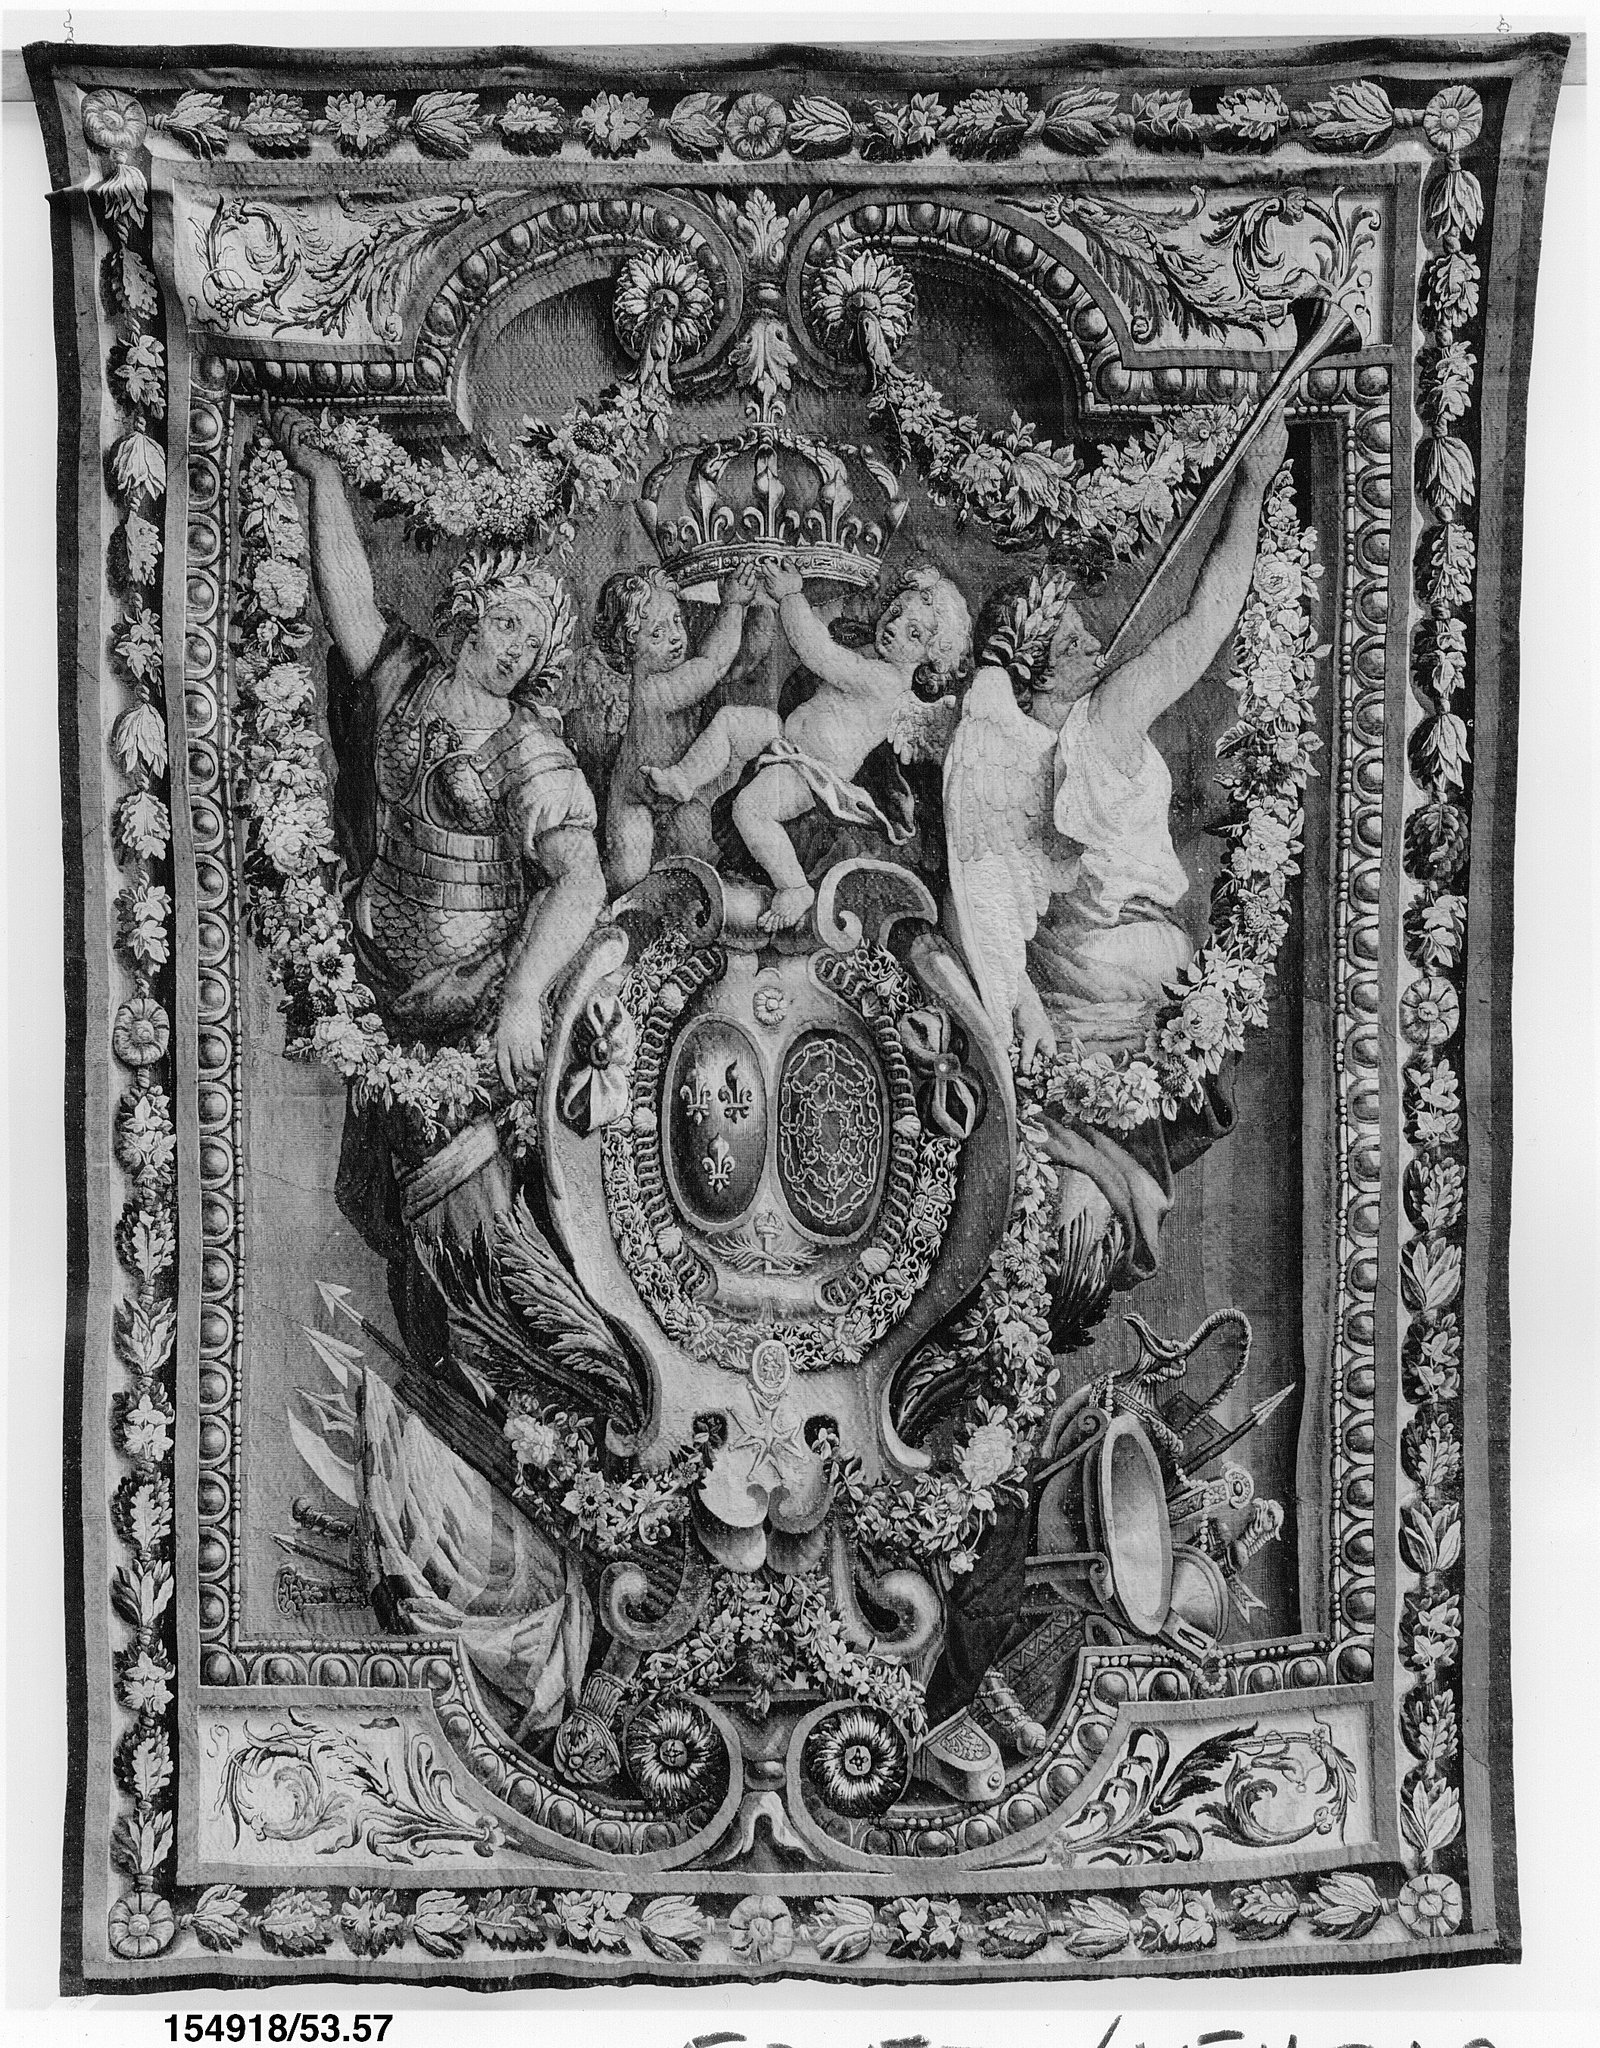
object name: armorial hanging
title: Portière des Renommées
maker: manufacture nationale des gobelins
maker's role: manufactory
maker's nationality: french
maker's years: 1662-1799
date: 1667-1700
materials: silk, wool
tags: putti,saints,coat of arms